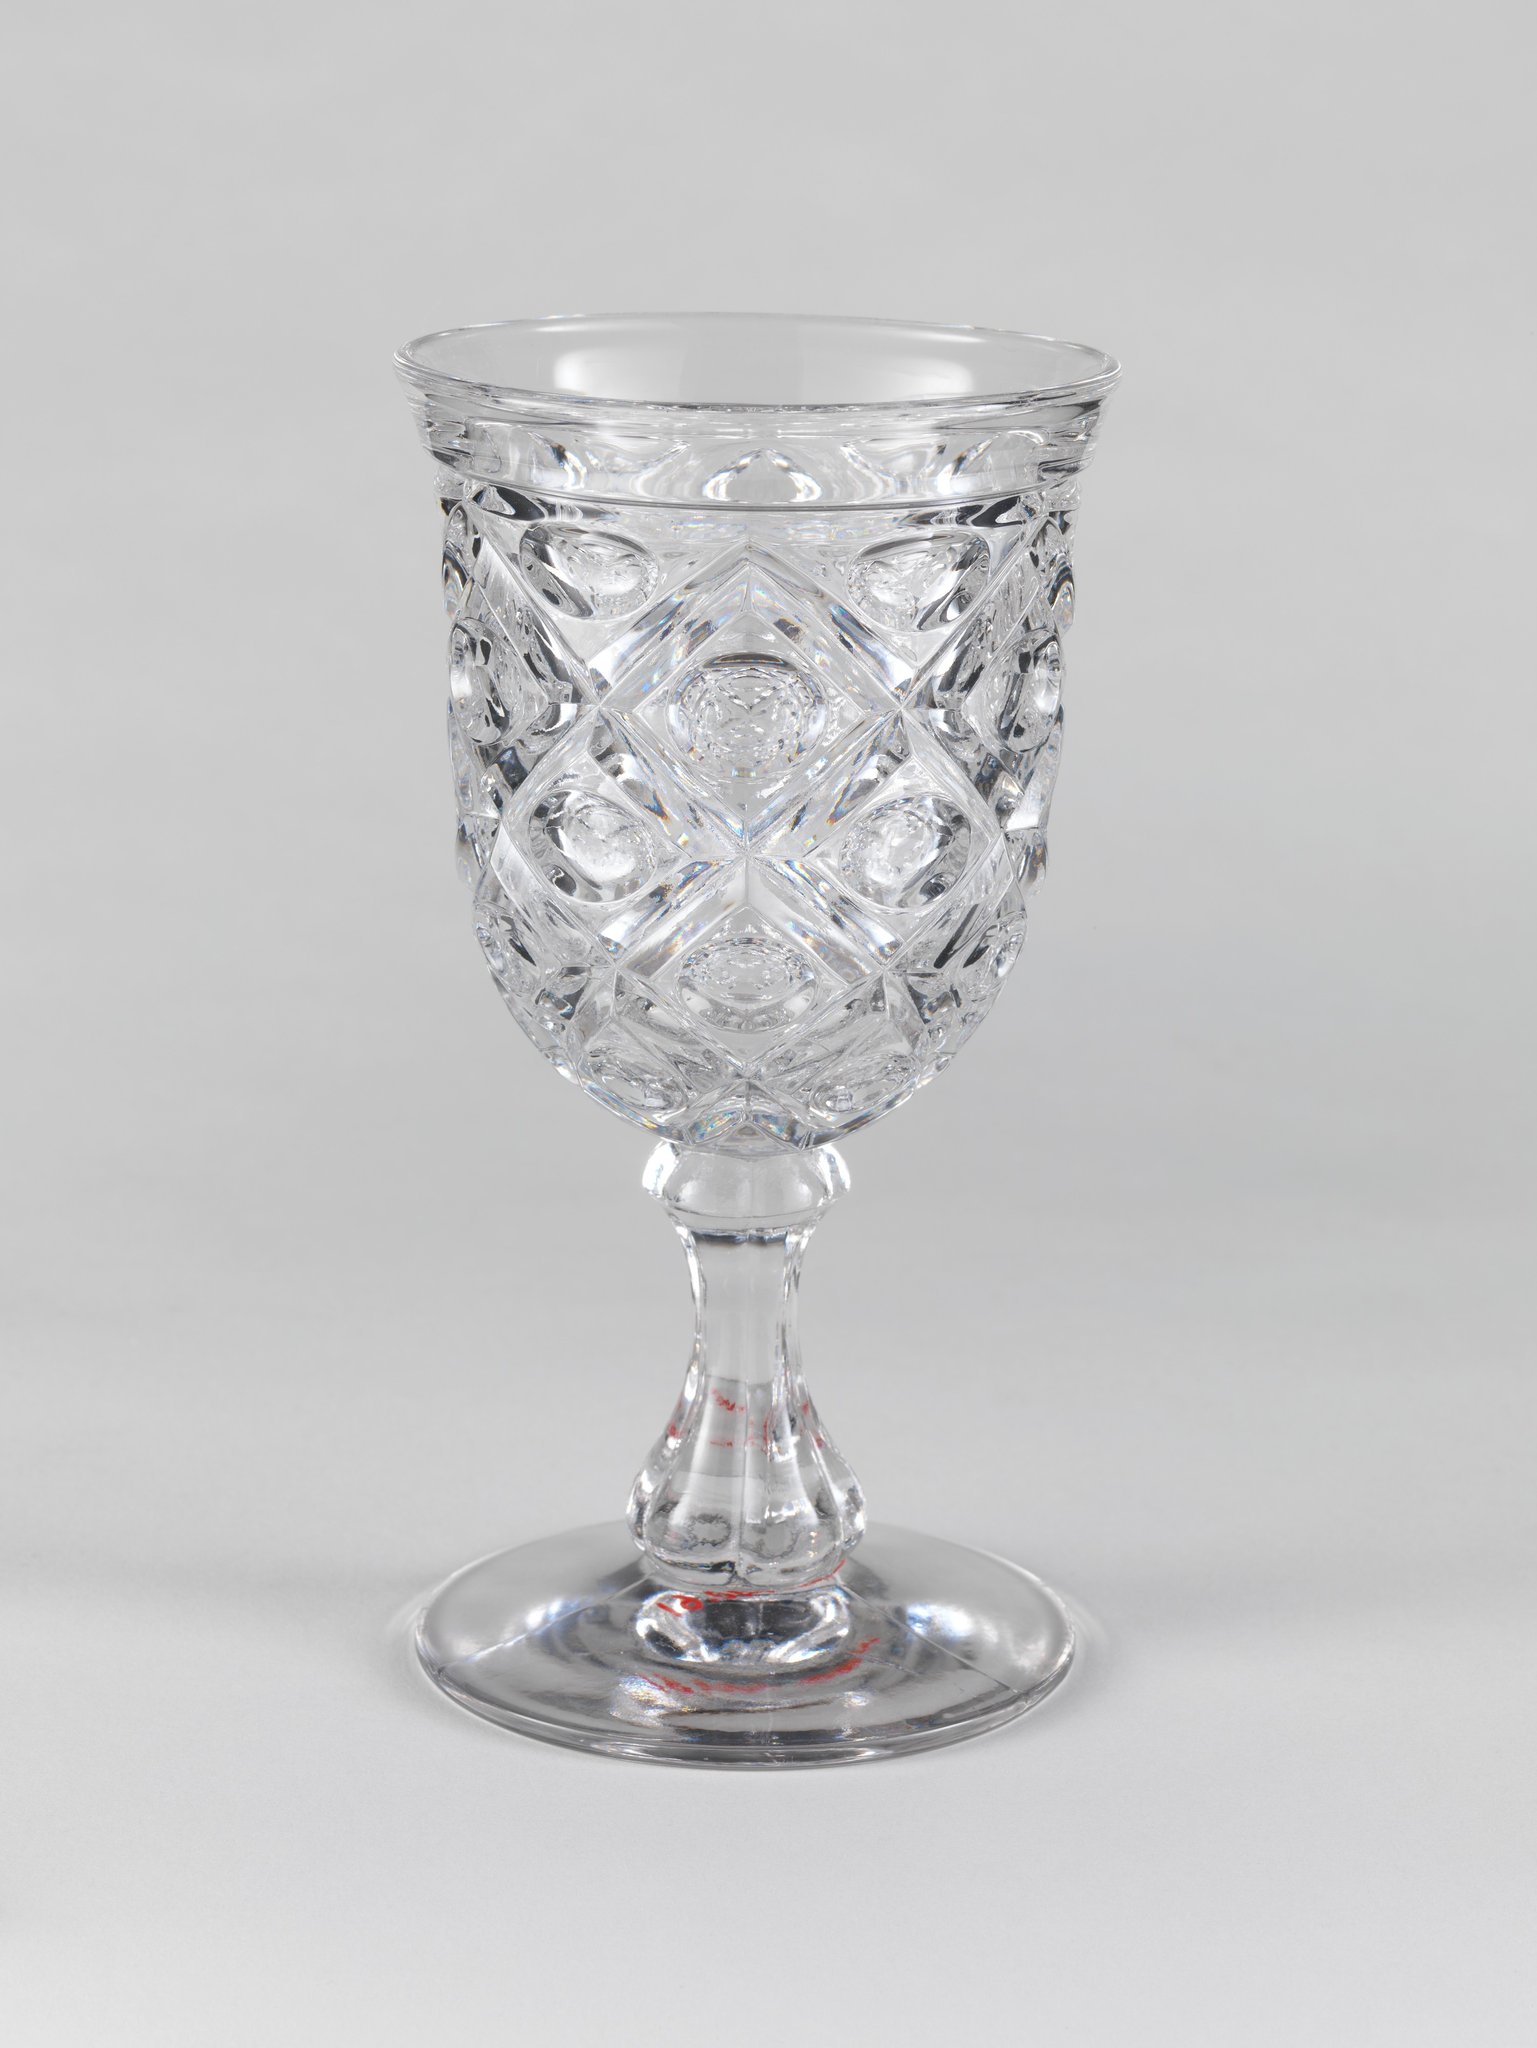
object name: goblet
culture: american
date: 1850-1860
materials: diamond, glass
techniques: pressed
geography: united states